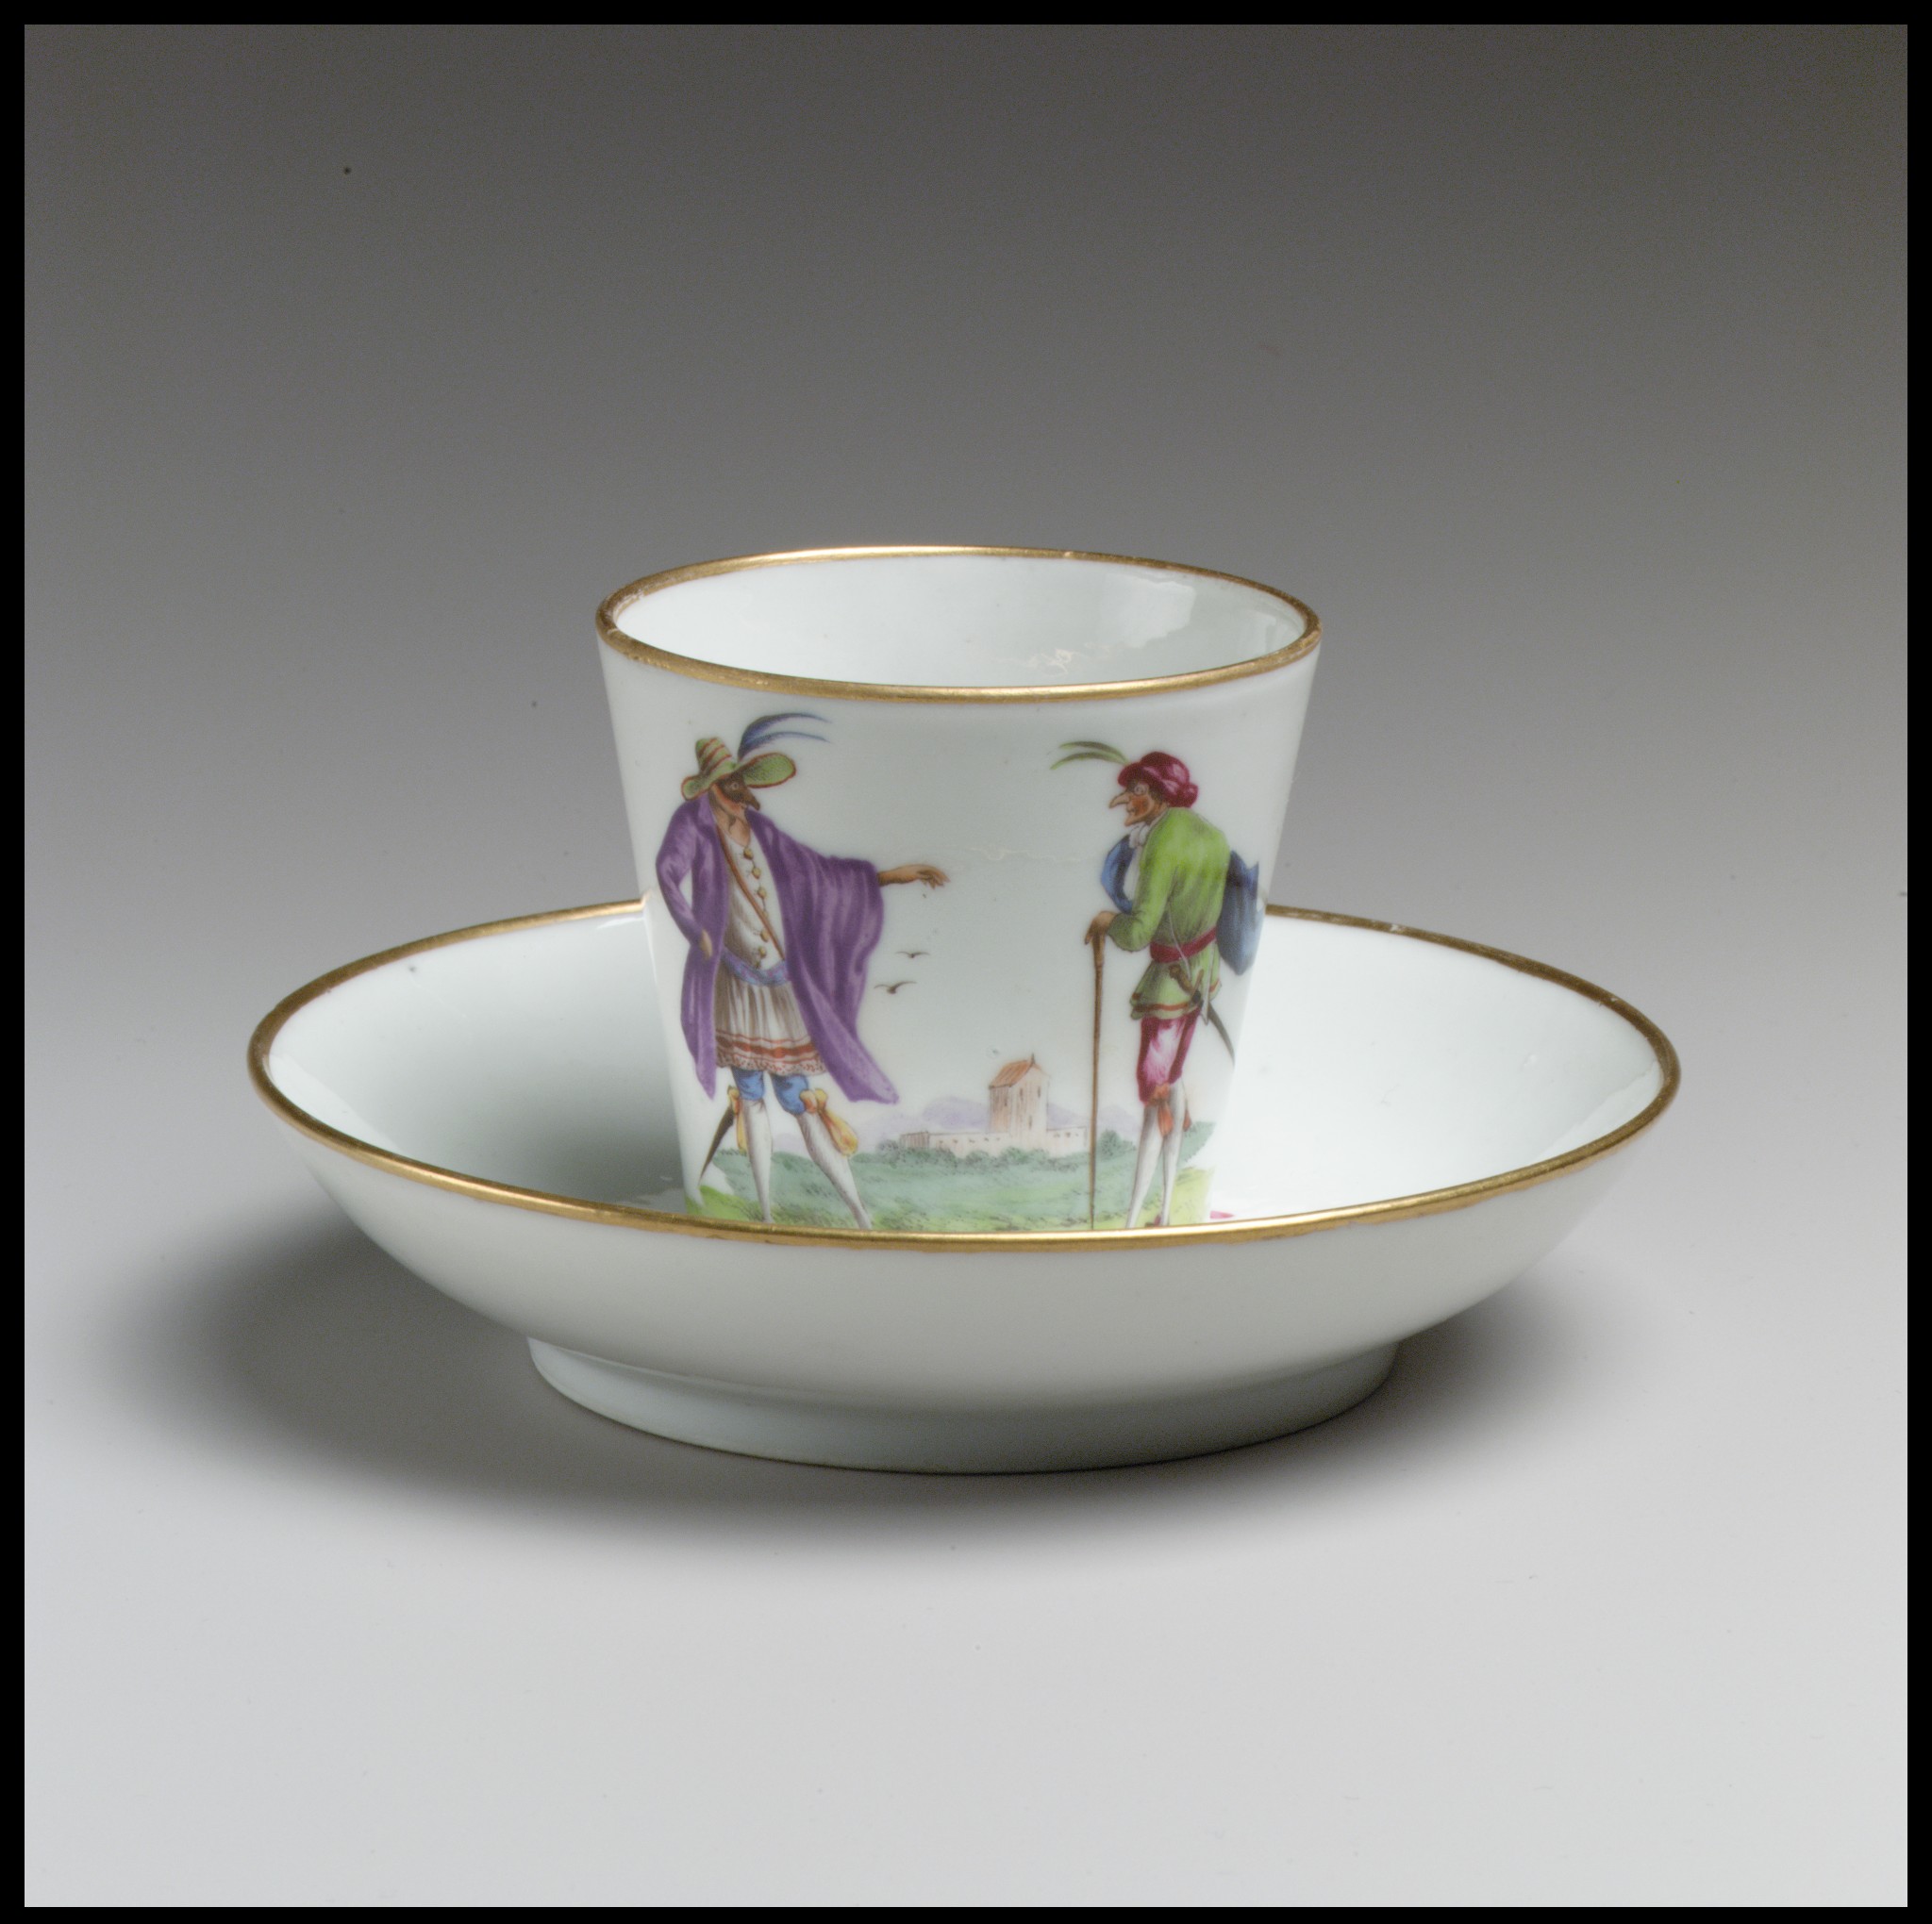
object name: beaker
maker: royal porcelain manufactory, naples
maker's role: manufactory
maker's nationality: italian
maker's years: 1759-1819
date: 1785-1795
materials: soft paste porcelain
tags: men